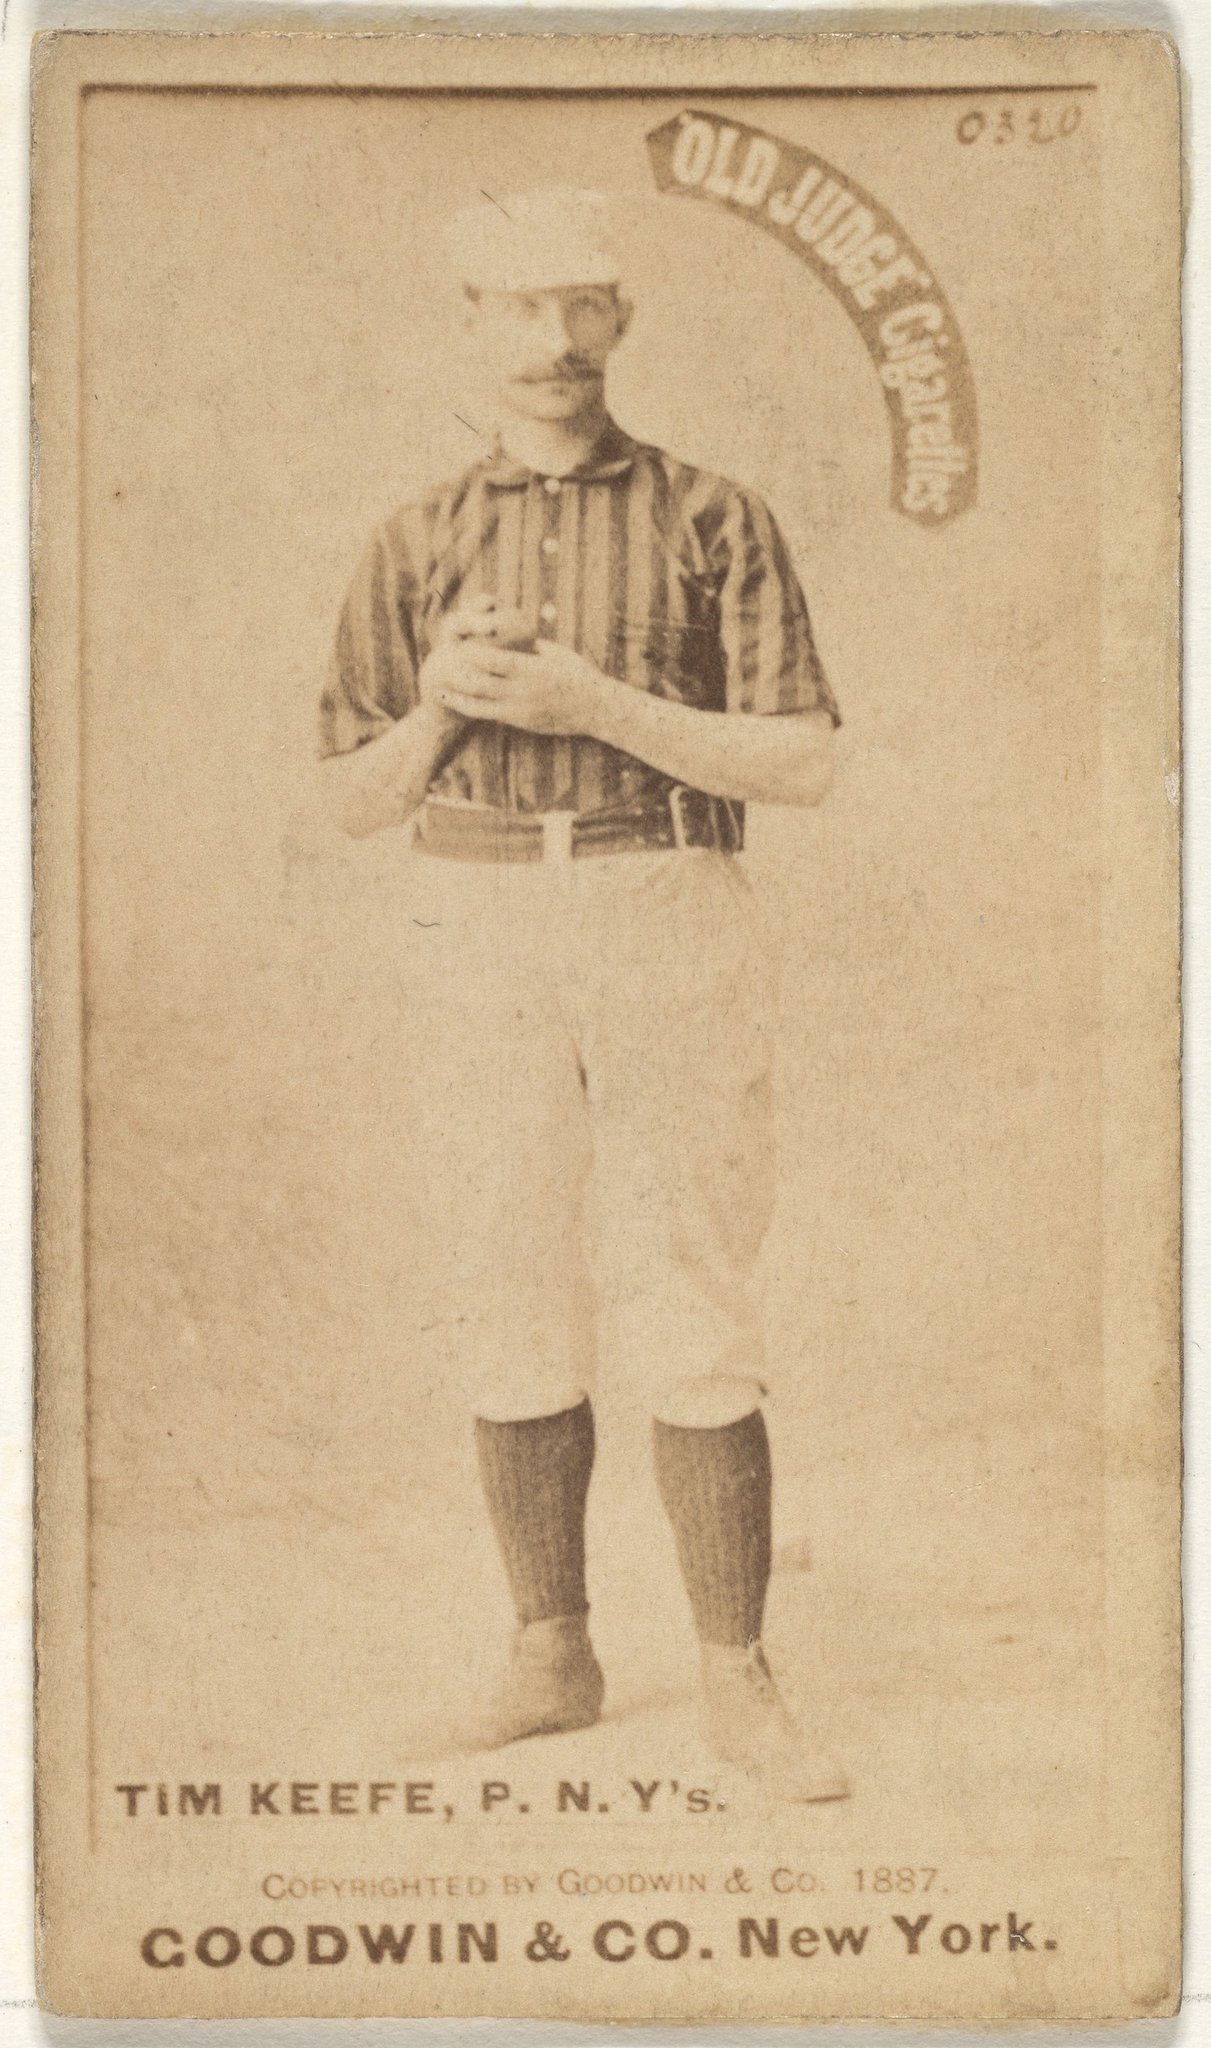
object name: baseball card, photograph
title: Timothy John "Tim" Keefe, Pitcher, New York, from the Old Judge series (N172) for Old Judge Cigarettes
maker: goodwin & company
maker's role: publisher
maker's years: 1850-1950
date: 1887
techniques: albumen silver print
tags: men,portraits,baseball,athletes